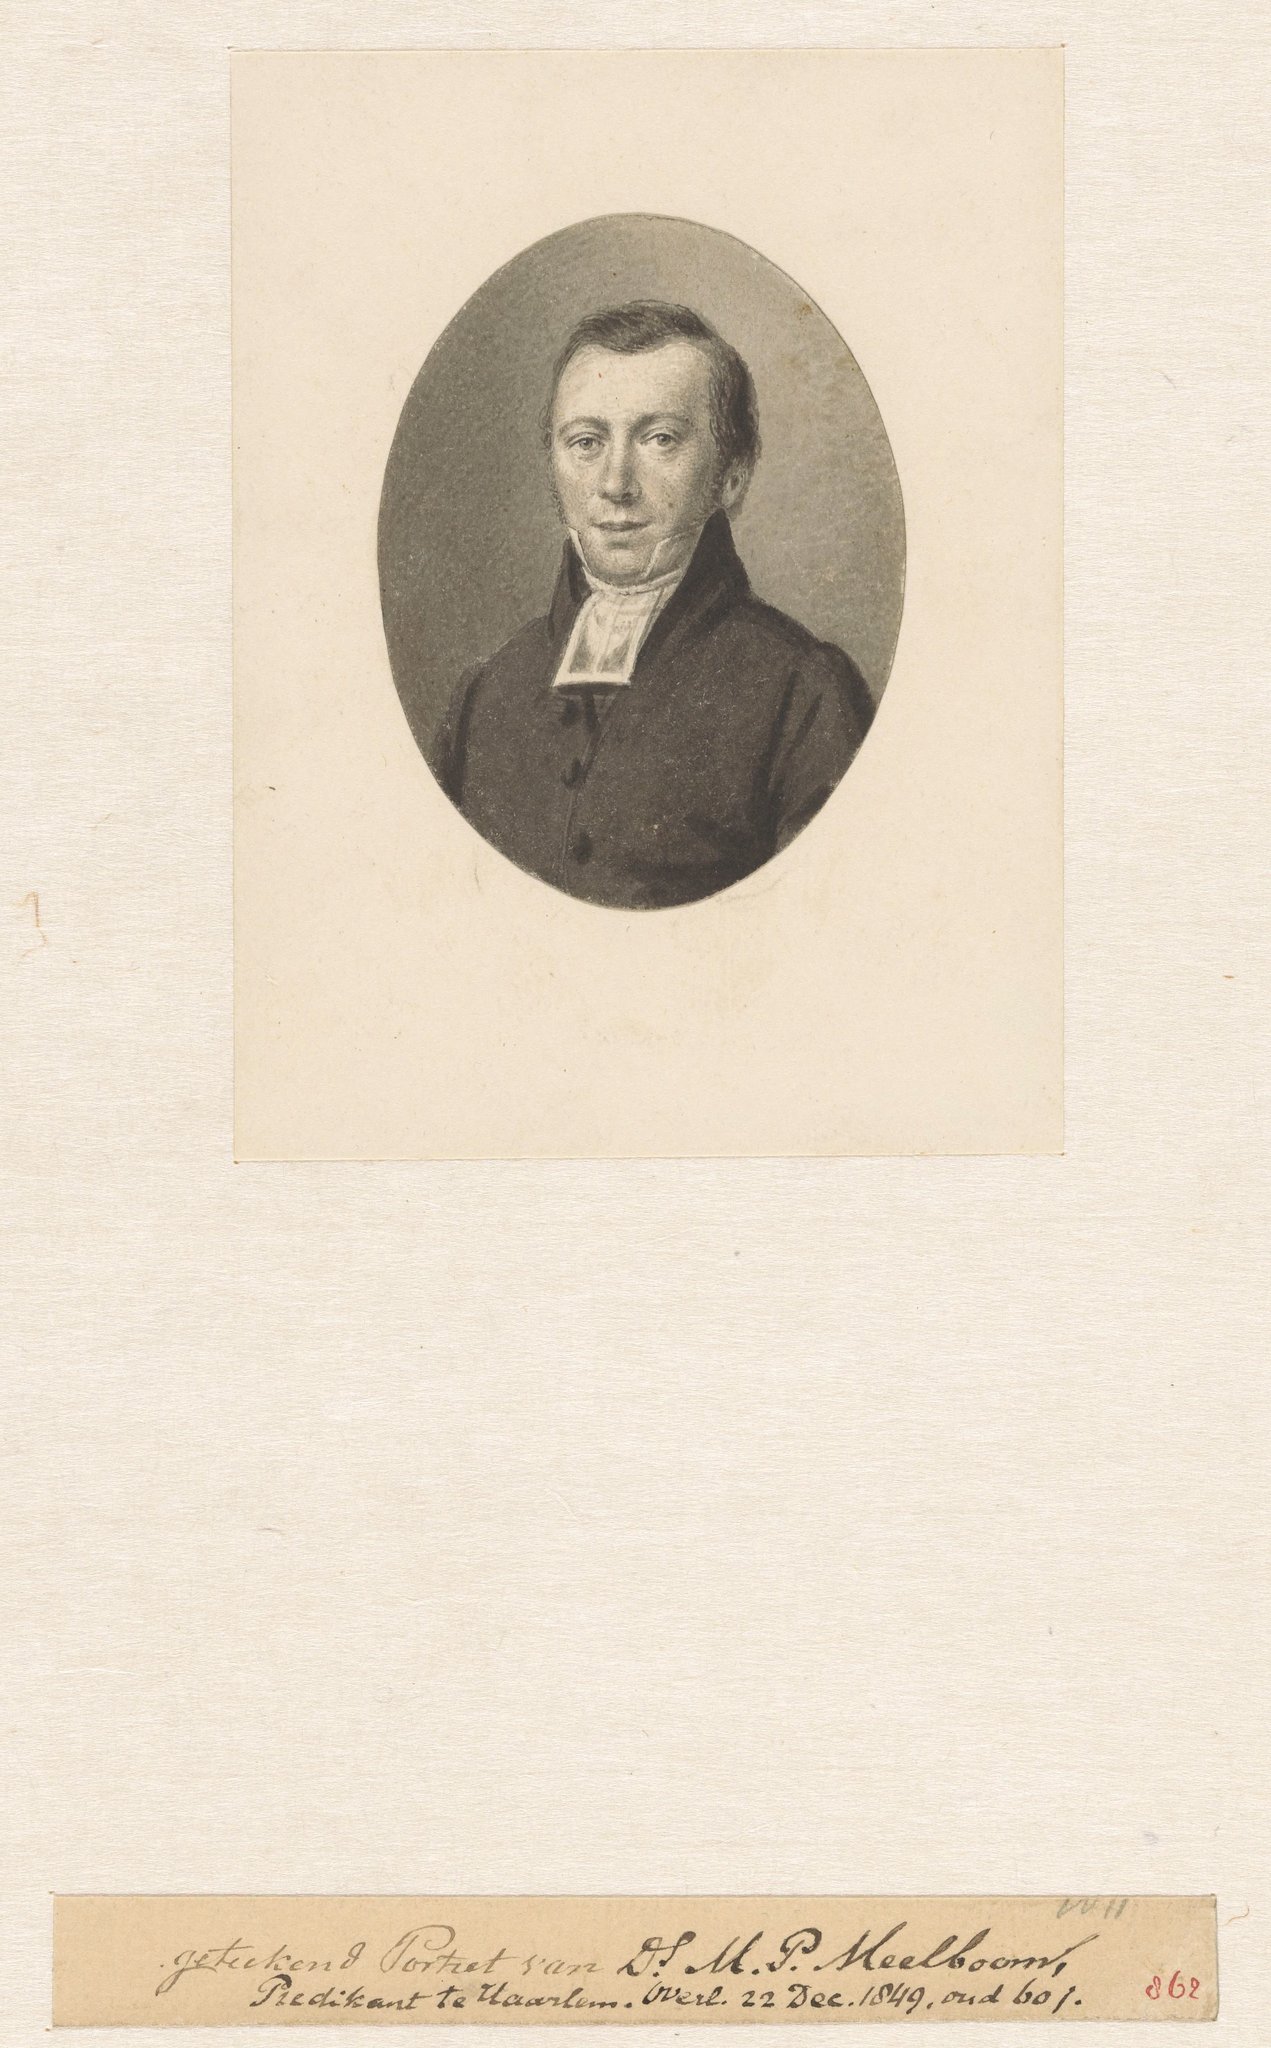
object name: drawing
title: Portret van Ds. M.P. Meelboom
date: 1780-1829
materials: ink, paper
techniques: brush, pen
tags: historical persons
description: Portret van Ds. M.P. Meelboom, predikant te Haarlem.